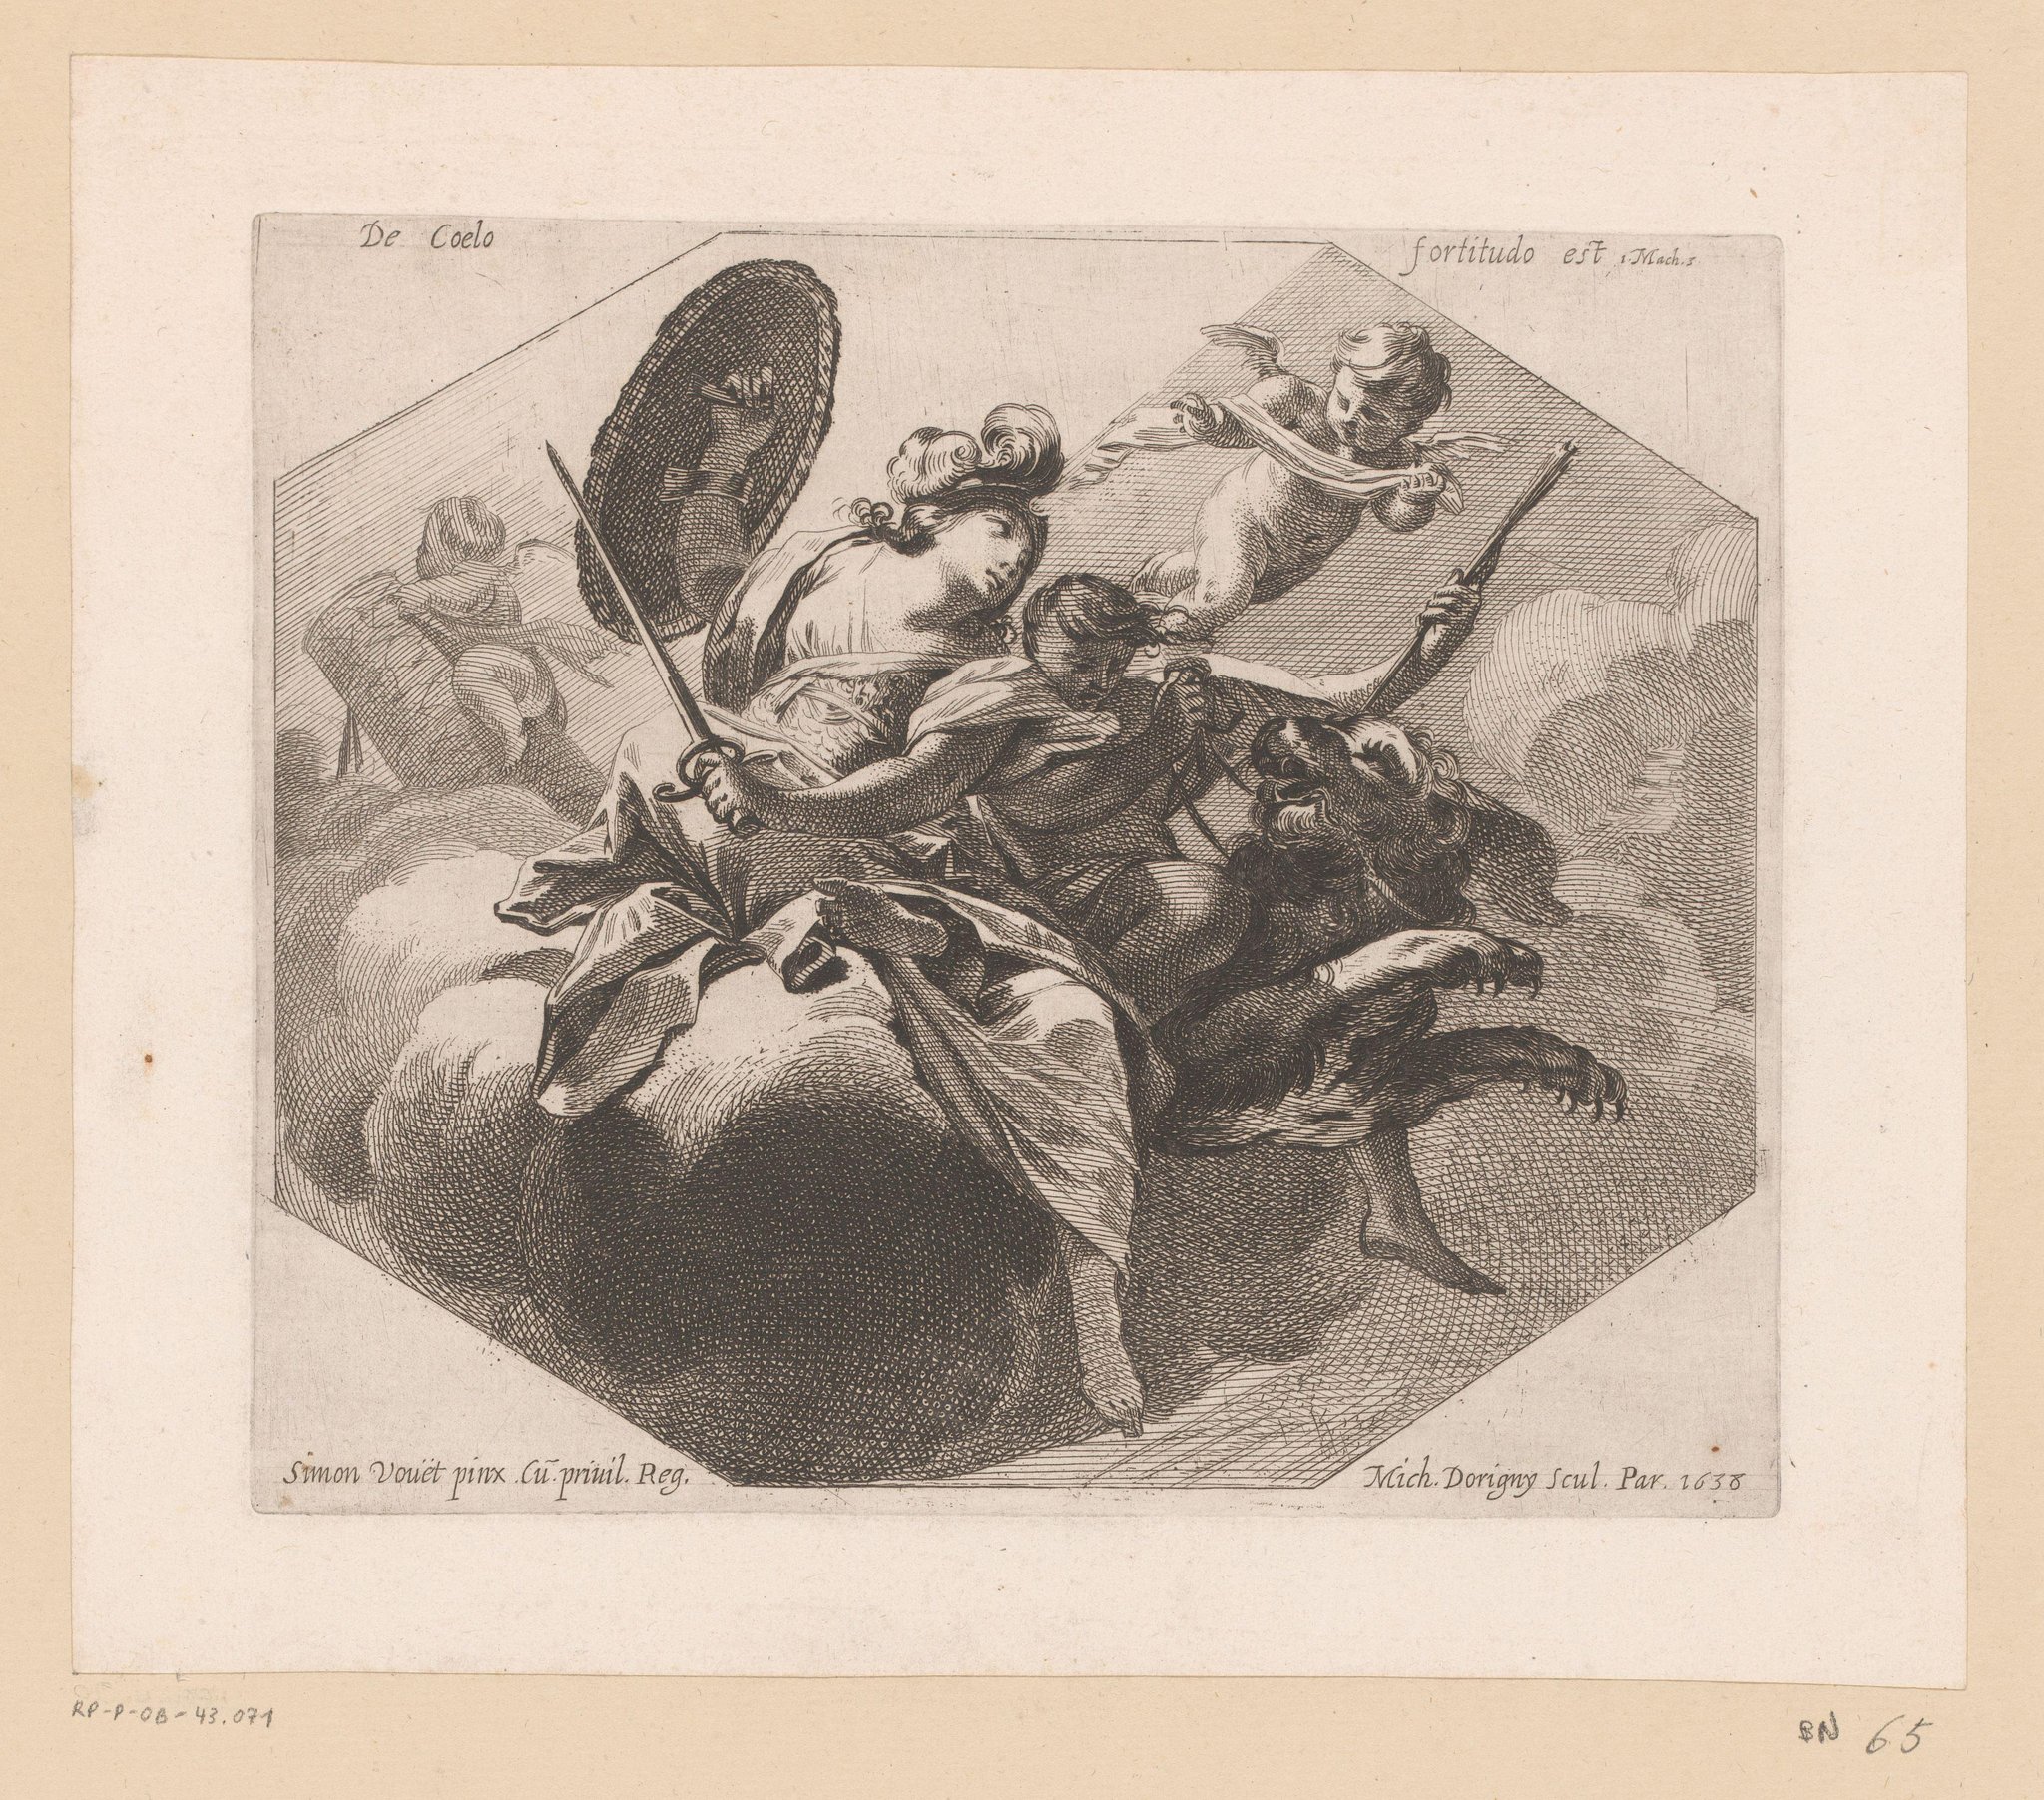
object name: print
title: Kardinale deugden op een wolk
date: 1638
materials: paper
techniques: engraving, etching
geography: paris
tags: fortitude, 'fortitudo' ~ one of the four cardinal virtues, assemblies of the gods in the air, possibly on the clouds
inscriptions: collector's mark: Lugt 240